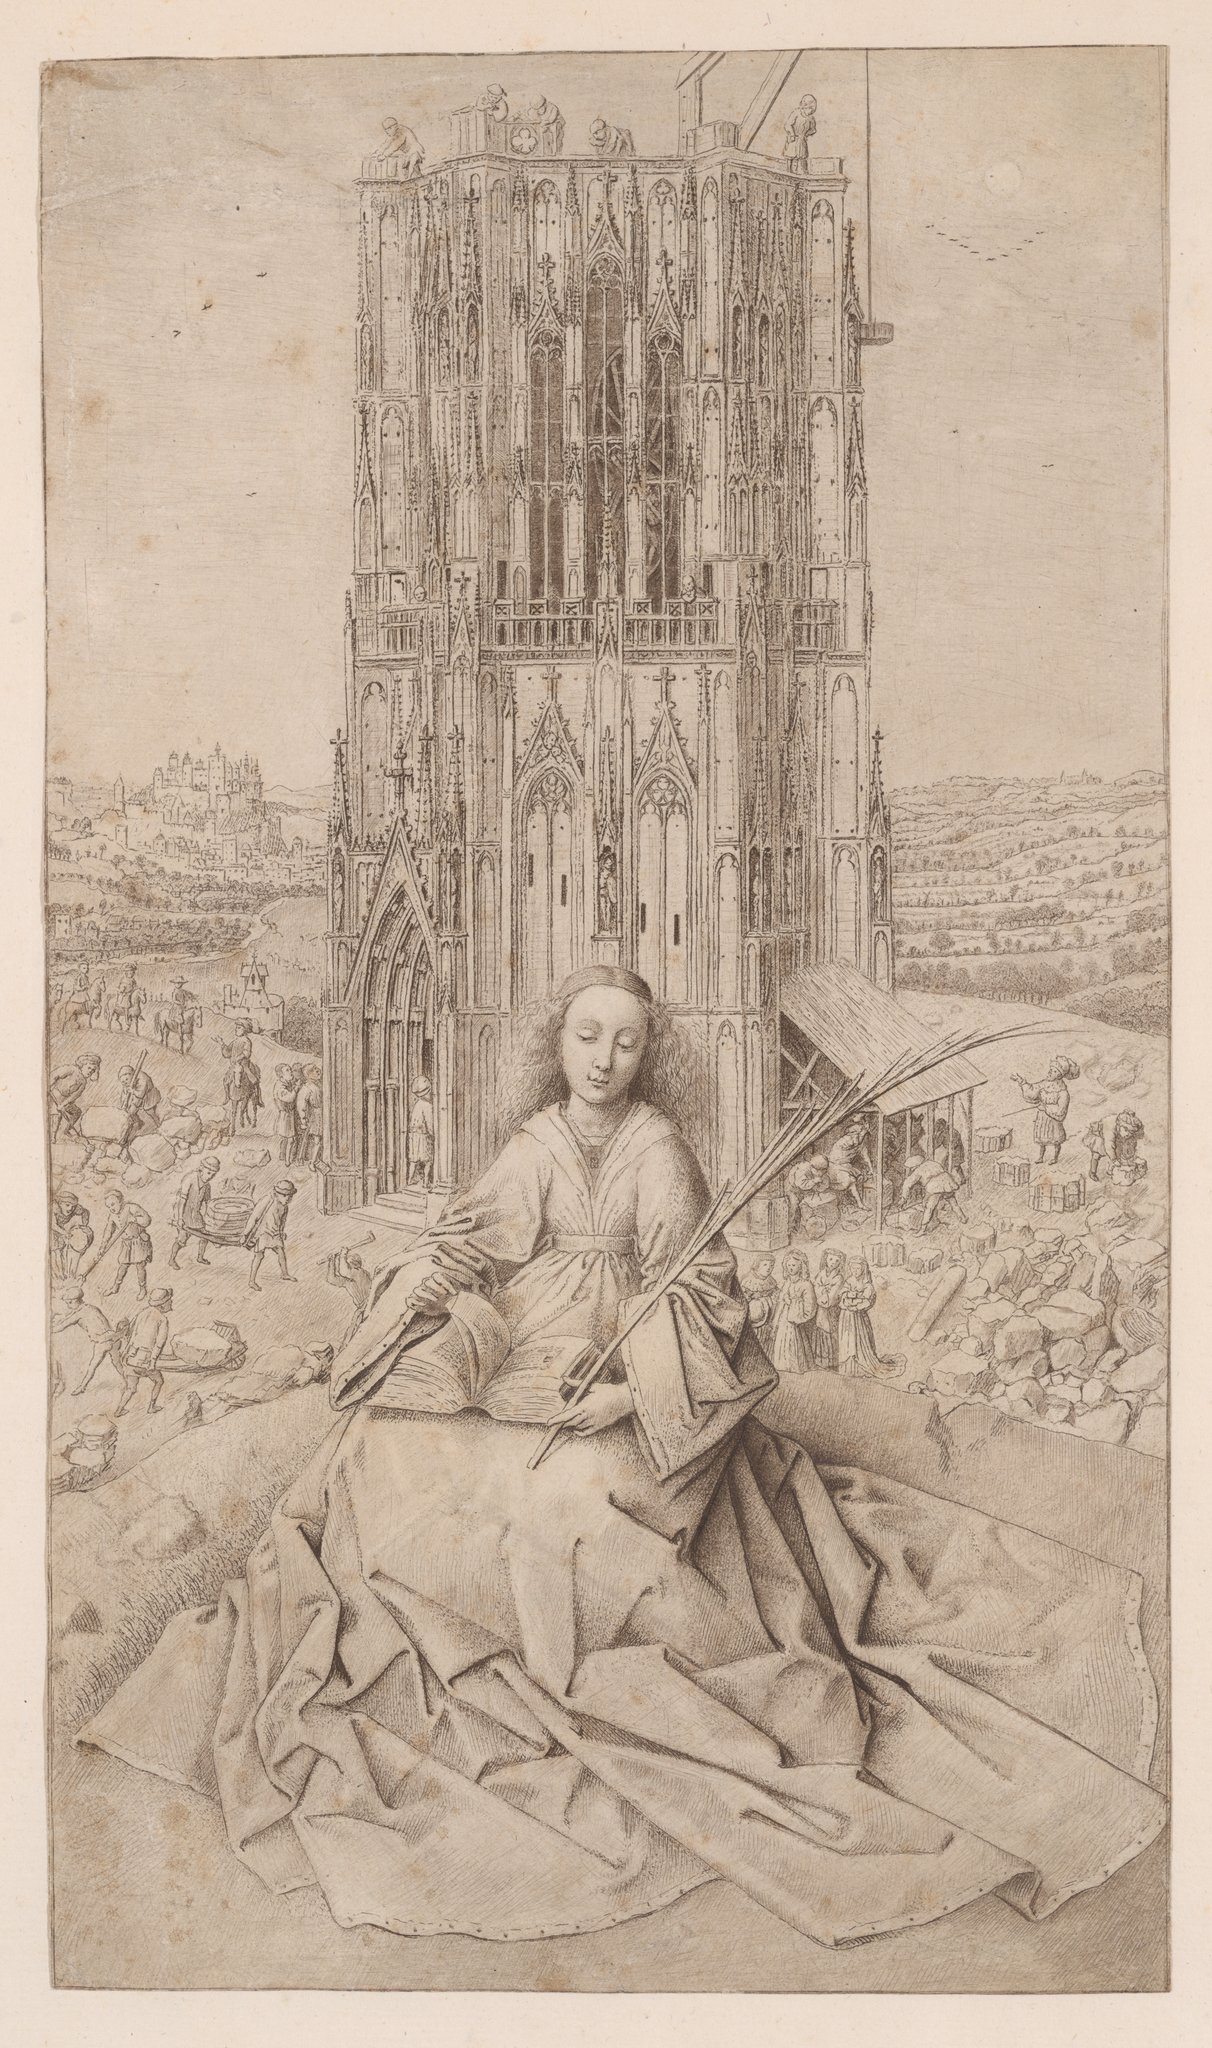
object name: print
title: Saint Barbara, Seated Before her Tower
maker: cornelis van noorde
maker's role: artist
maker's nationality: netherlandish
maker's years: 1731-1795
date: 1769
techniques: drypoint, etching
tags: towers,women,saints